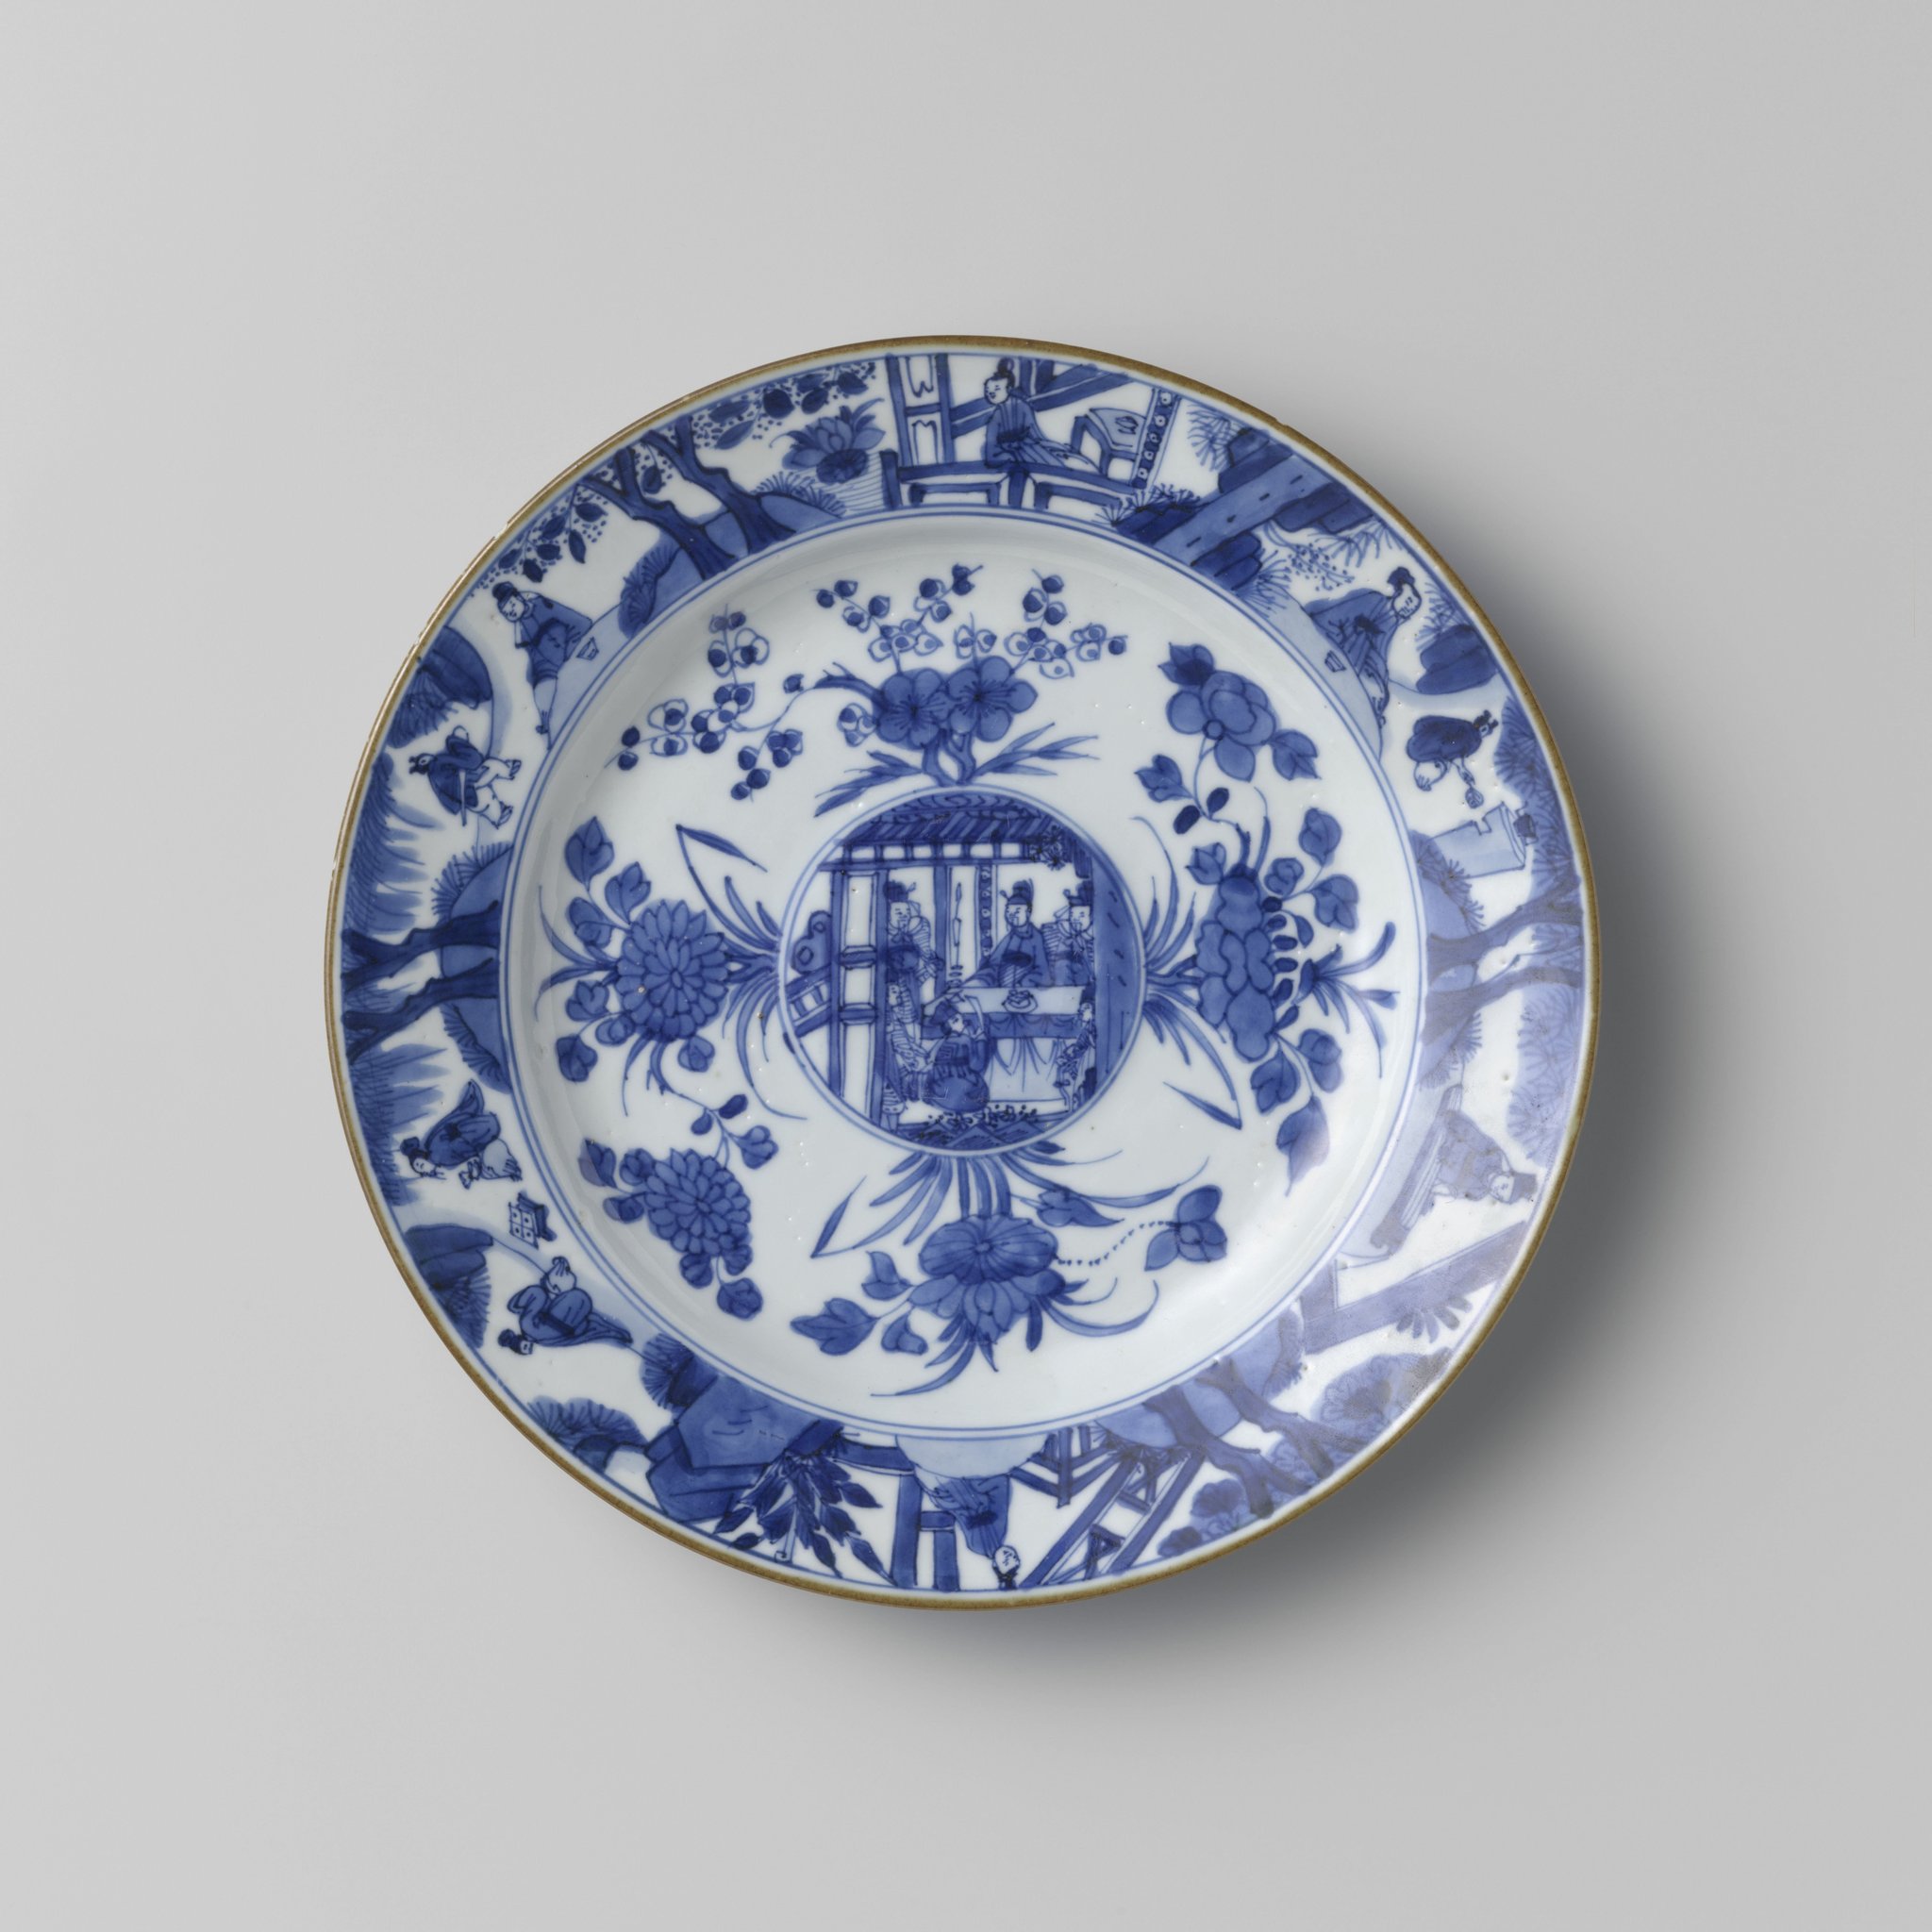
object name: plate dish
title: Plate with flower sprays and figures in an interior and in a landscape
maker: Anonymous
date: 1700-1724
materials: cobalt, glaze, paint, porcelain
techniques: firing, turning, vitrification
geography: china